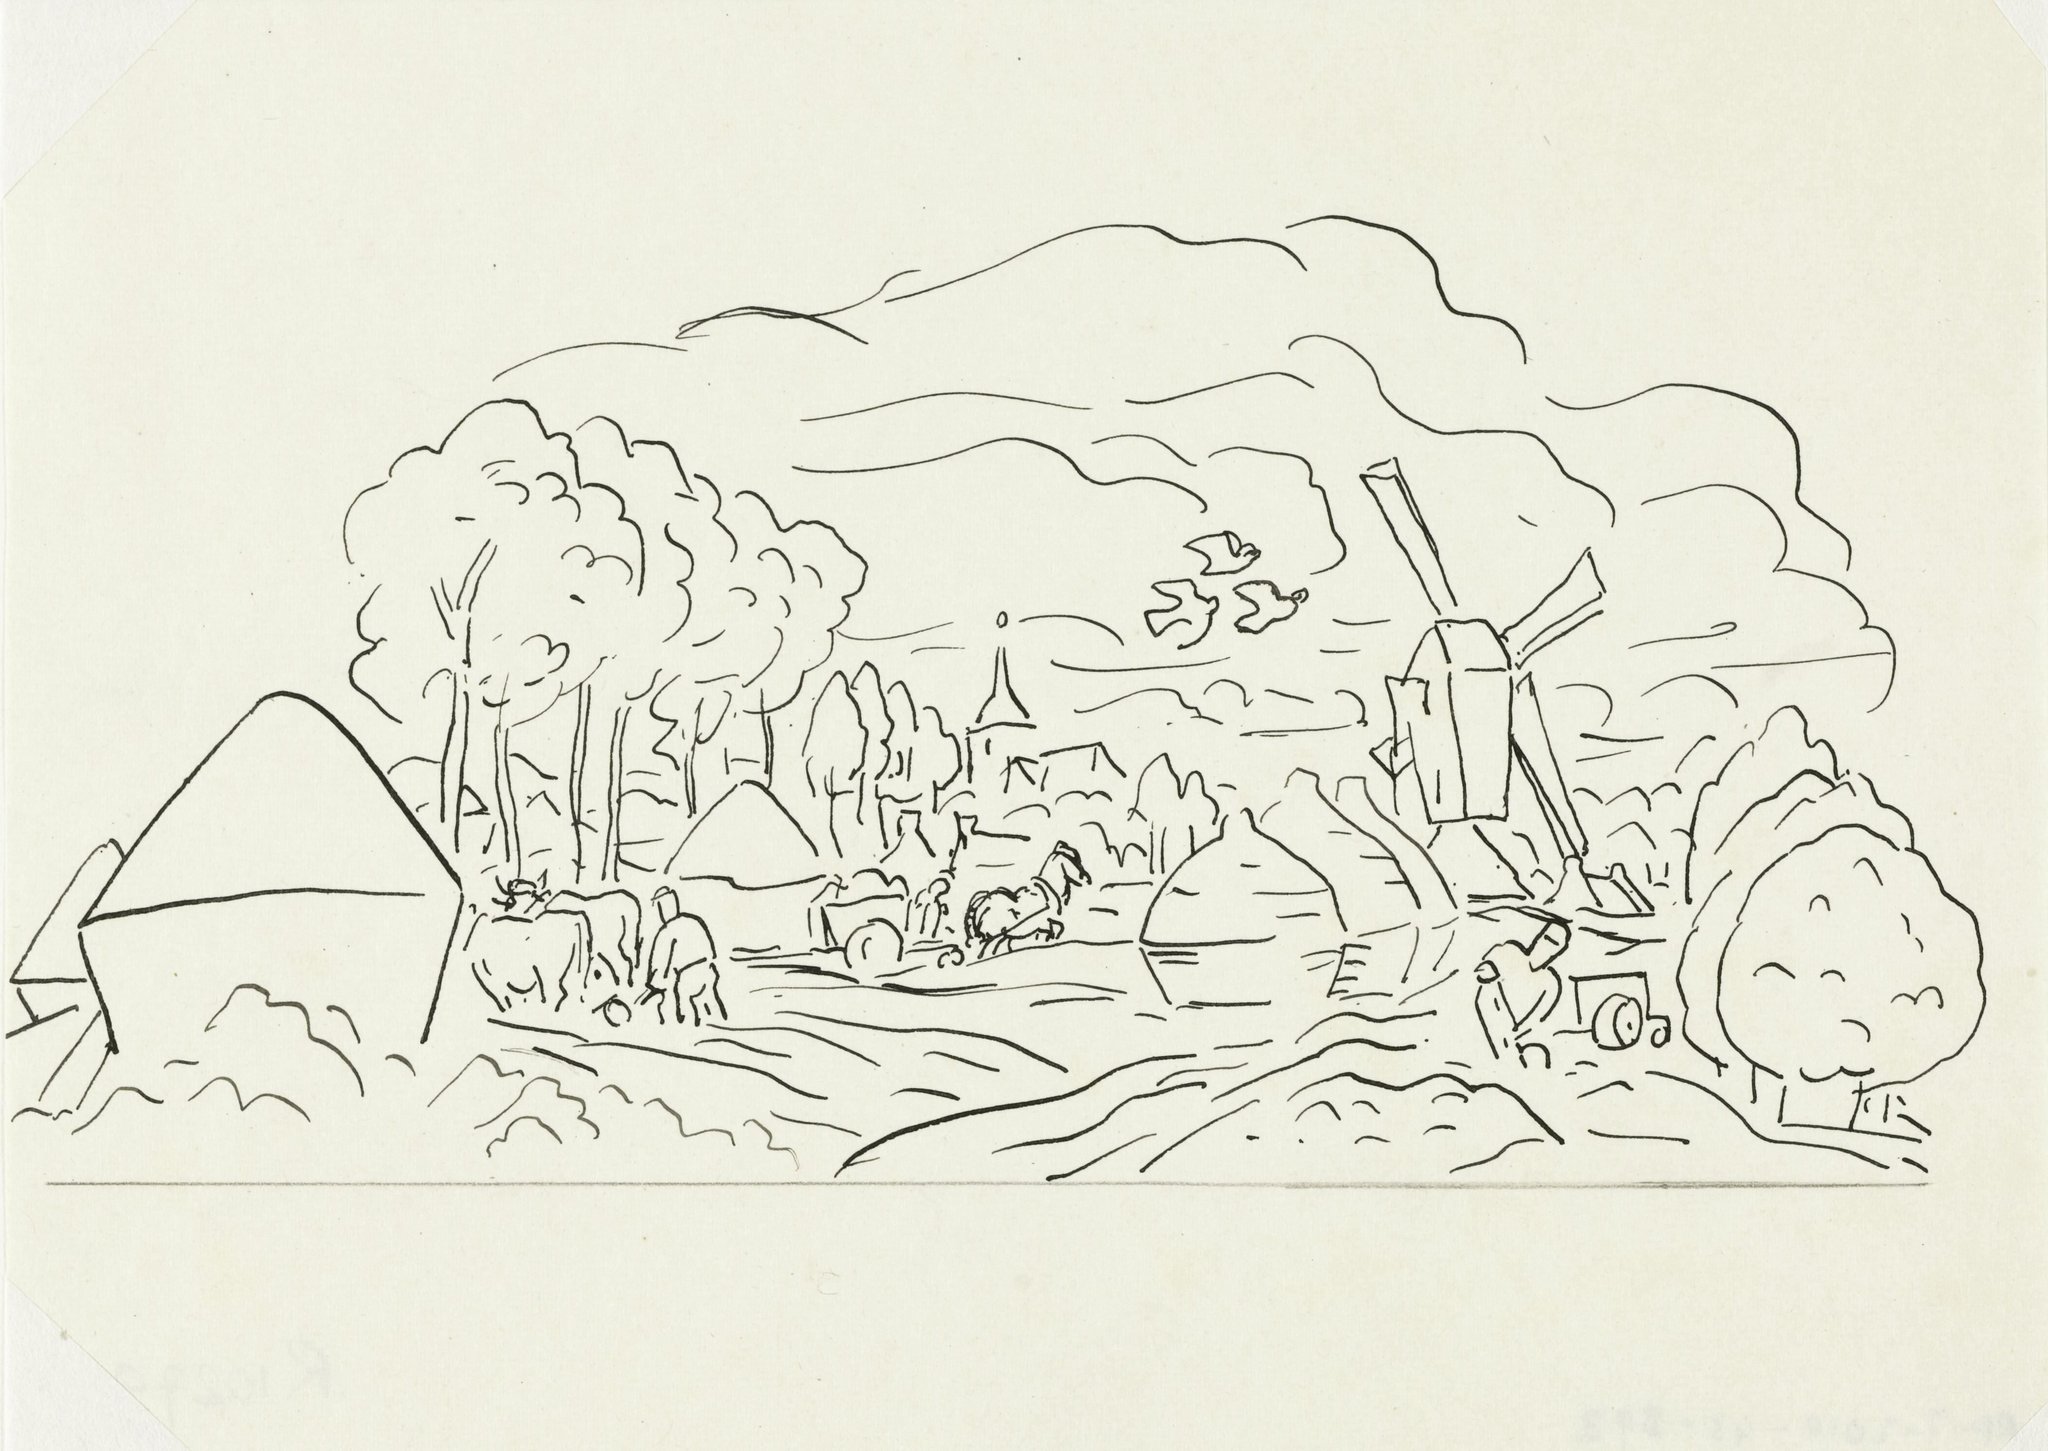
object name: drawing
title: Vignet voor biografie van Gestel door Prof. W. van der Pluym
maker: leo gestel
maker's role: draughtsman, print maker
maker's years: 1881-1941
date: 1935-1936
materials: ink, paper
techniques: pen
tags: print maker, draughtsman, leo gestel, village, hay-stack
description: Landschap met hooimijten, molen, kerktoren, ploegende boer en boeren met paard en wagen, links van de molenwieken drie vogels in vlucht